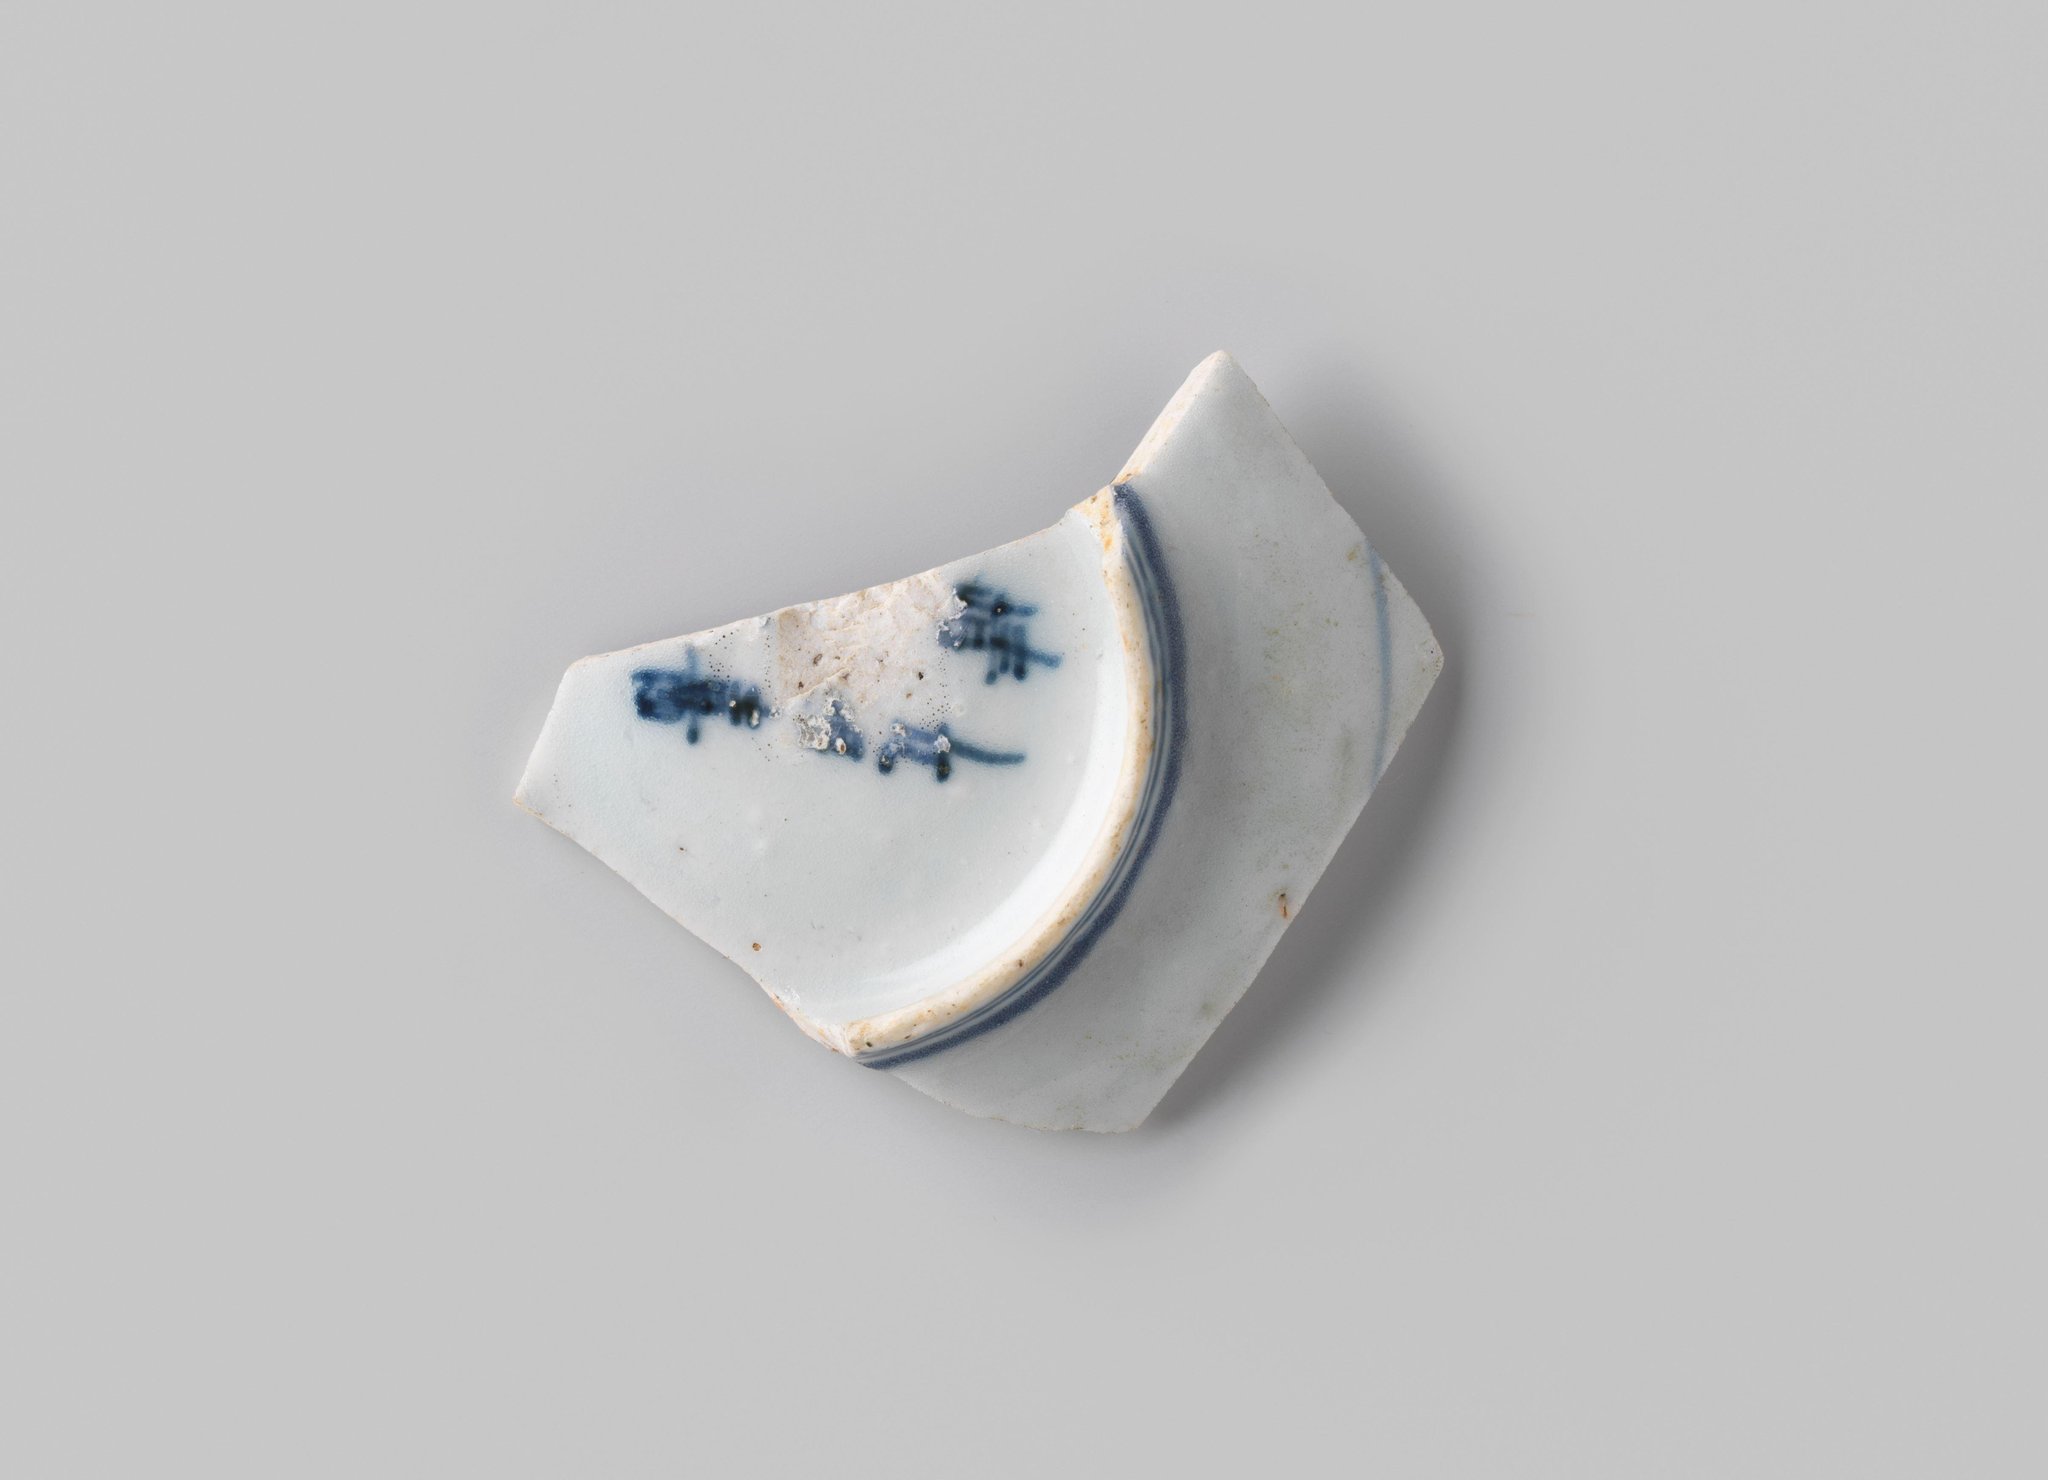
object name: plate dish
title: Fragment bord uit V.O.C.-schip de 'Witte Leeuw'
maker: Anonymous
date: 1613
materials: porcelain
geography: jingdezhen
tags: verenigde oostindische compagnie, sint-helena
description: A dish with a flattened rim. On the flat part a design is visible of a lion amongst tassels, encircled by a band with a pattern of tiny rui heads. The cavetto is blank. On the rim a band with alternately symbols and flowers with tassels.